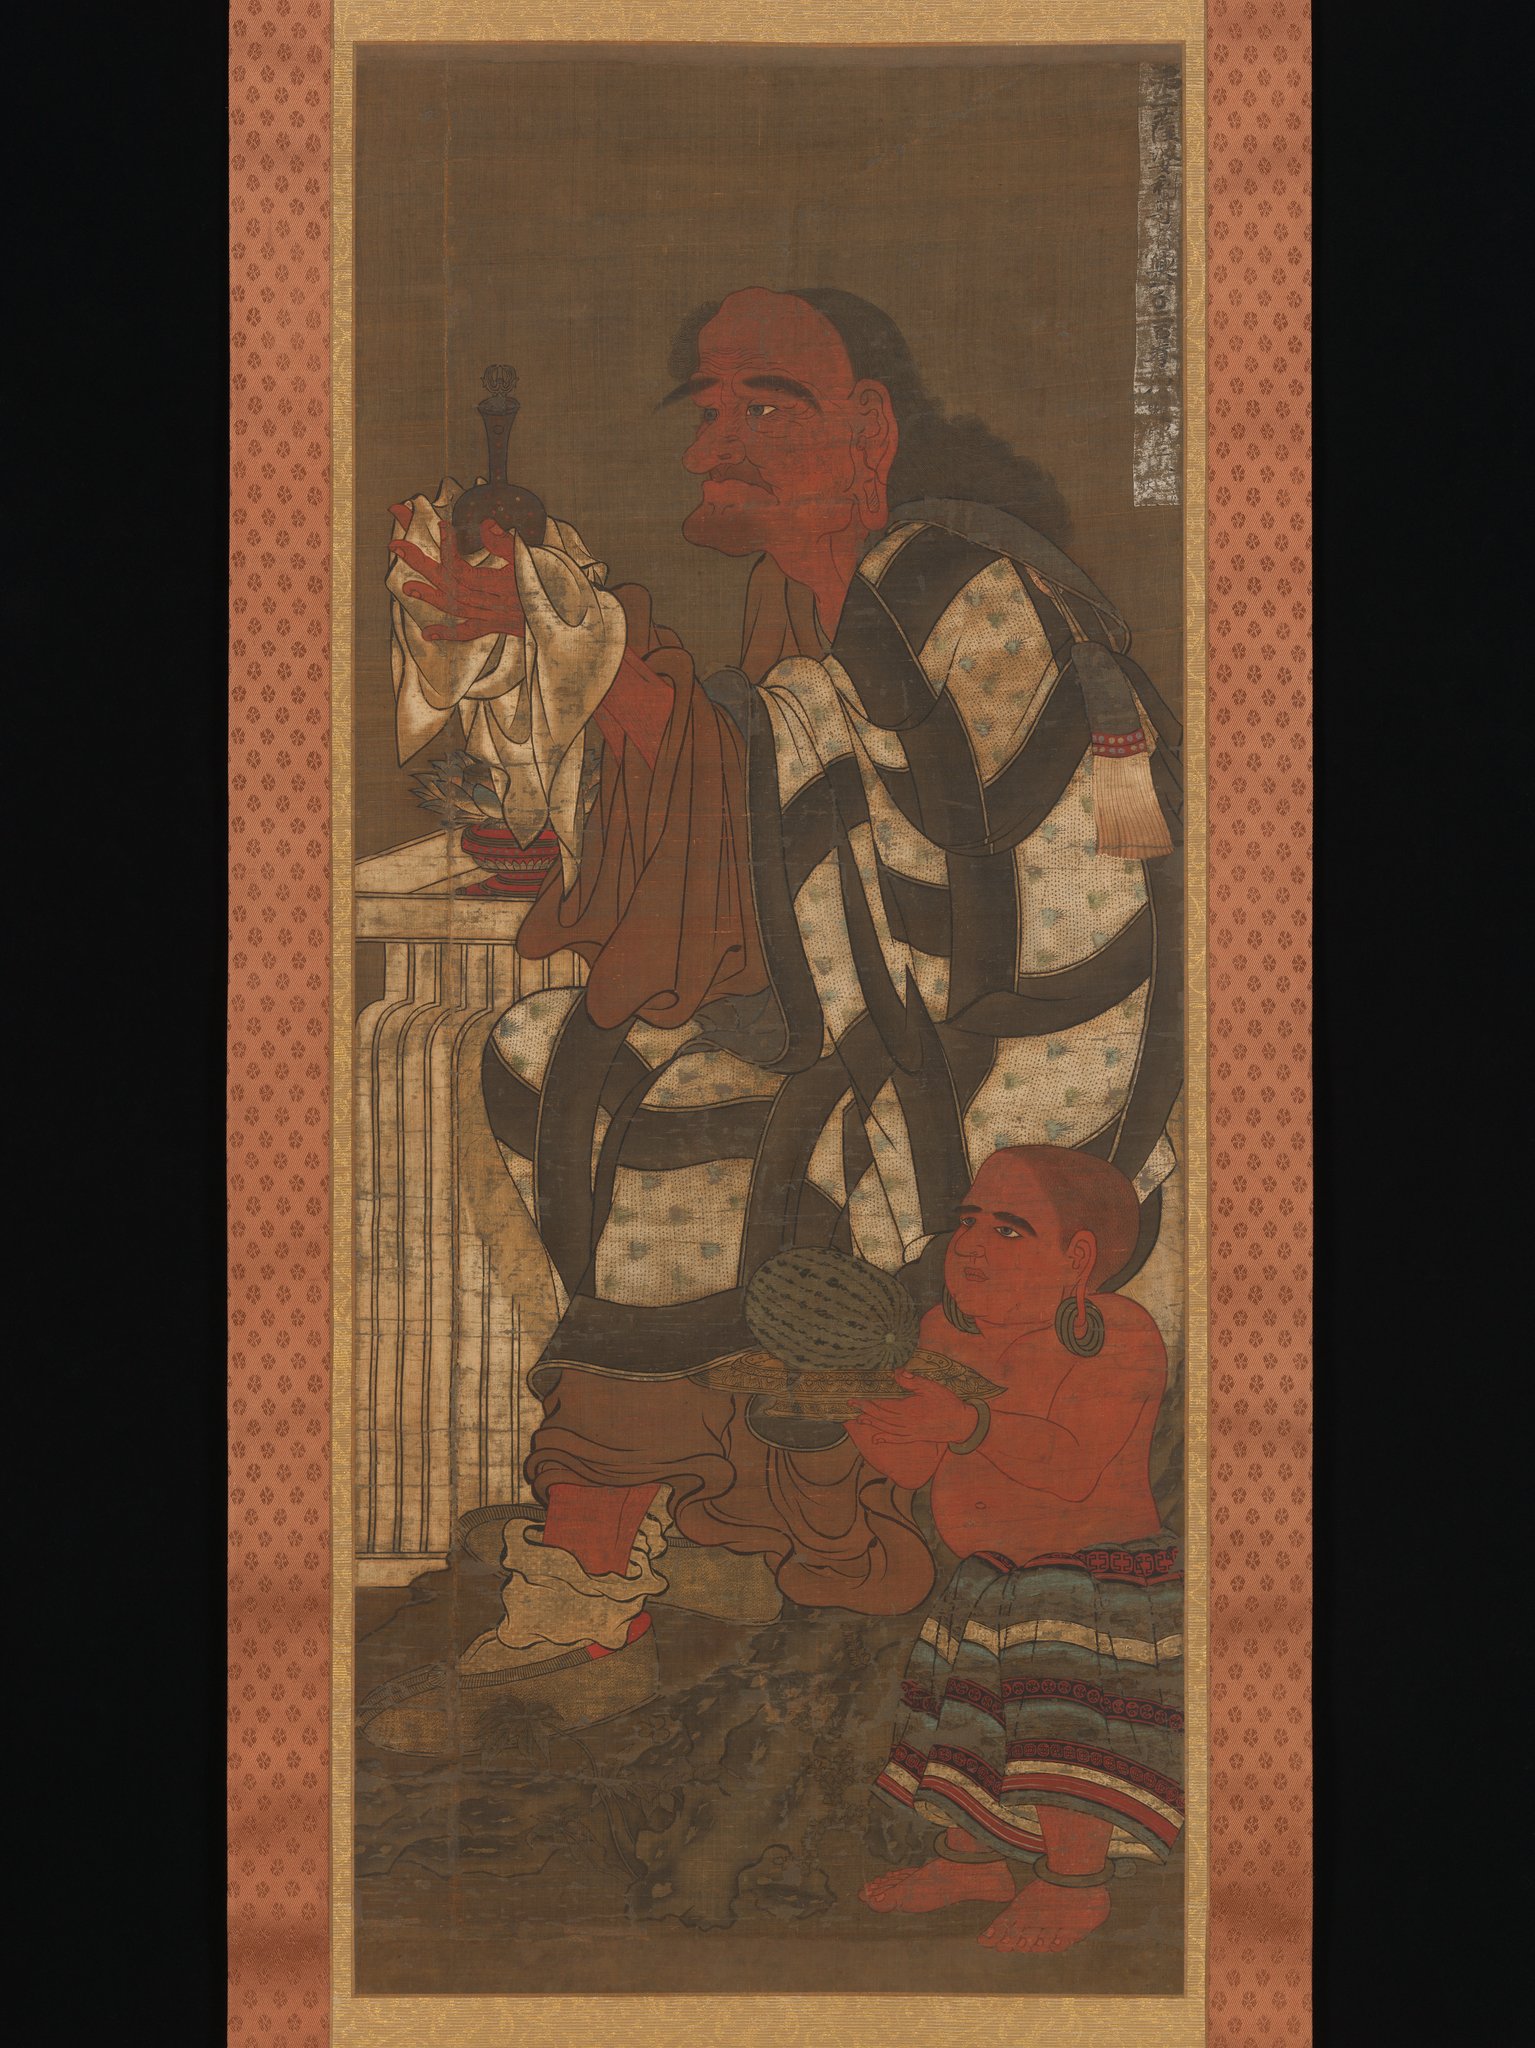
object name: hanging scroll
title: Satsubari, the Second of the Sixteen Arhats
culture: japanese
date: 1367-1400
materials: ink, silk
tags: men,buddhism